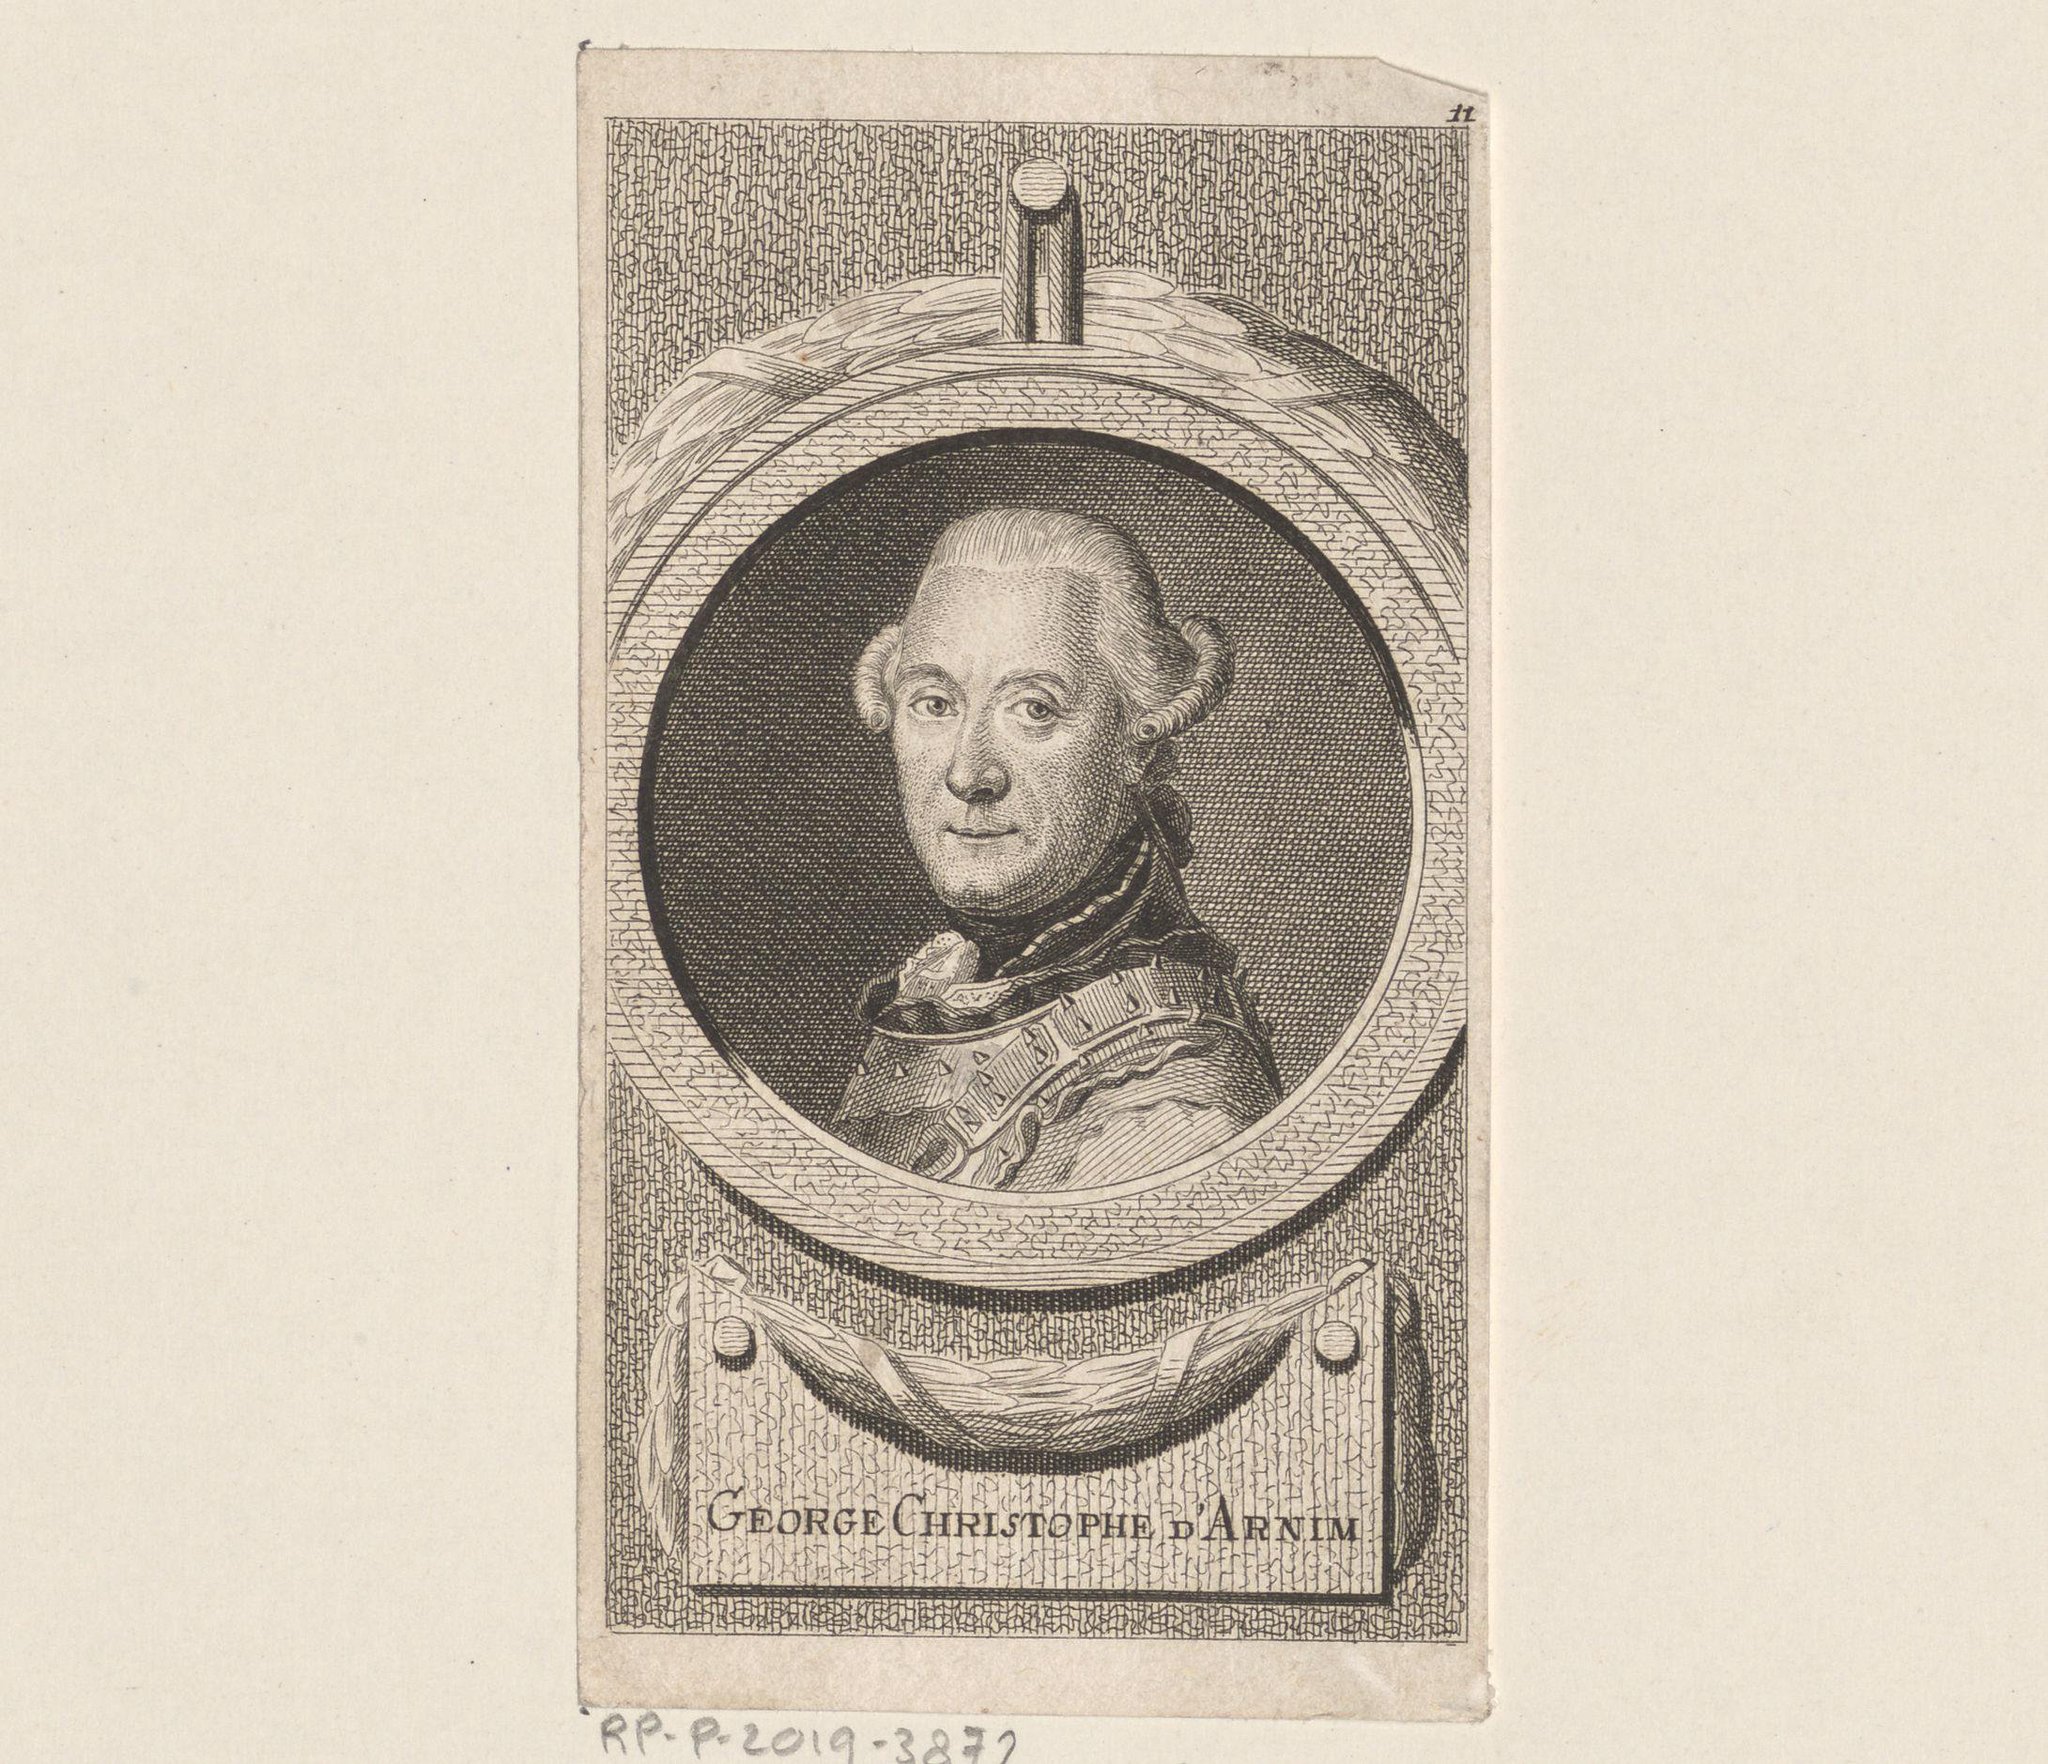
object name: print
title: Portret van George Christoph von Arnim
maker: Anonymous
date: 1750-1799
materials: paper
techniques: etching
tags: historical persons